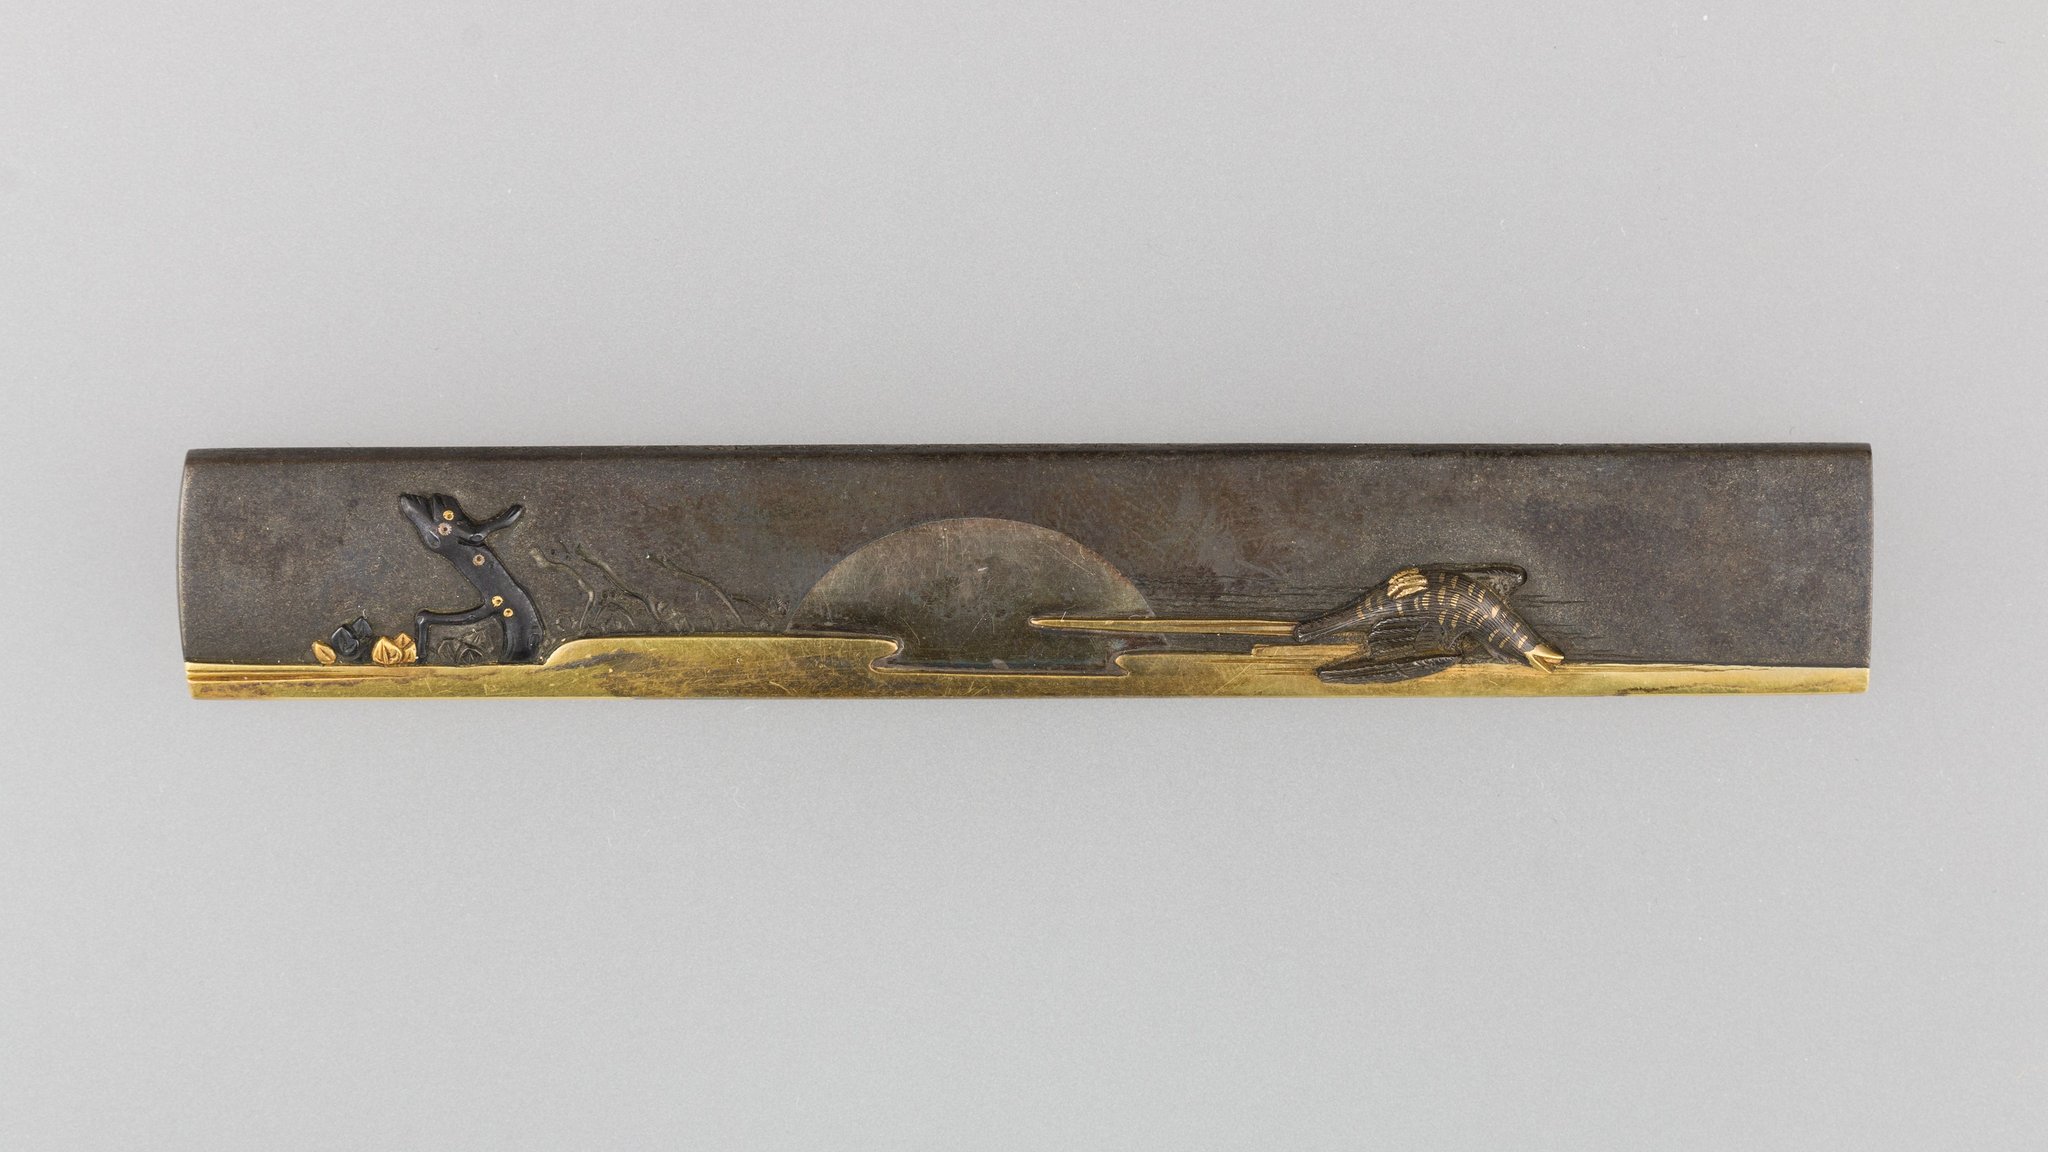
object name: knife handle kozuka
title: Knife Handle (Kozuka)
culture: japanese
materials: gold alloy, silver alloy, gold, silver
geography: japan